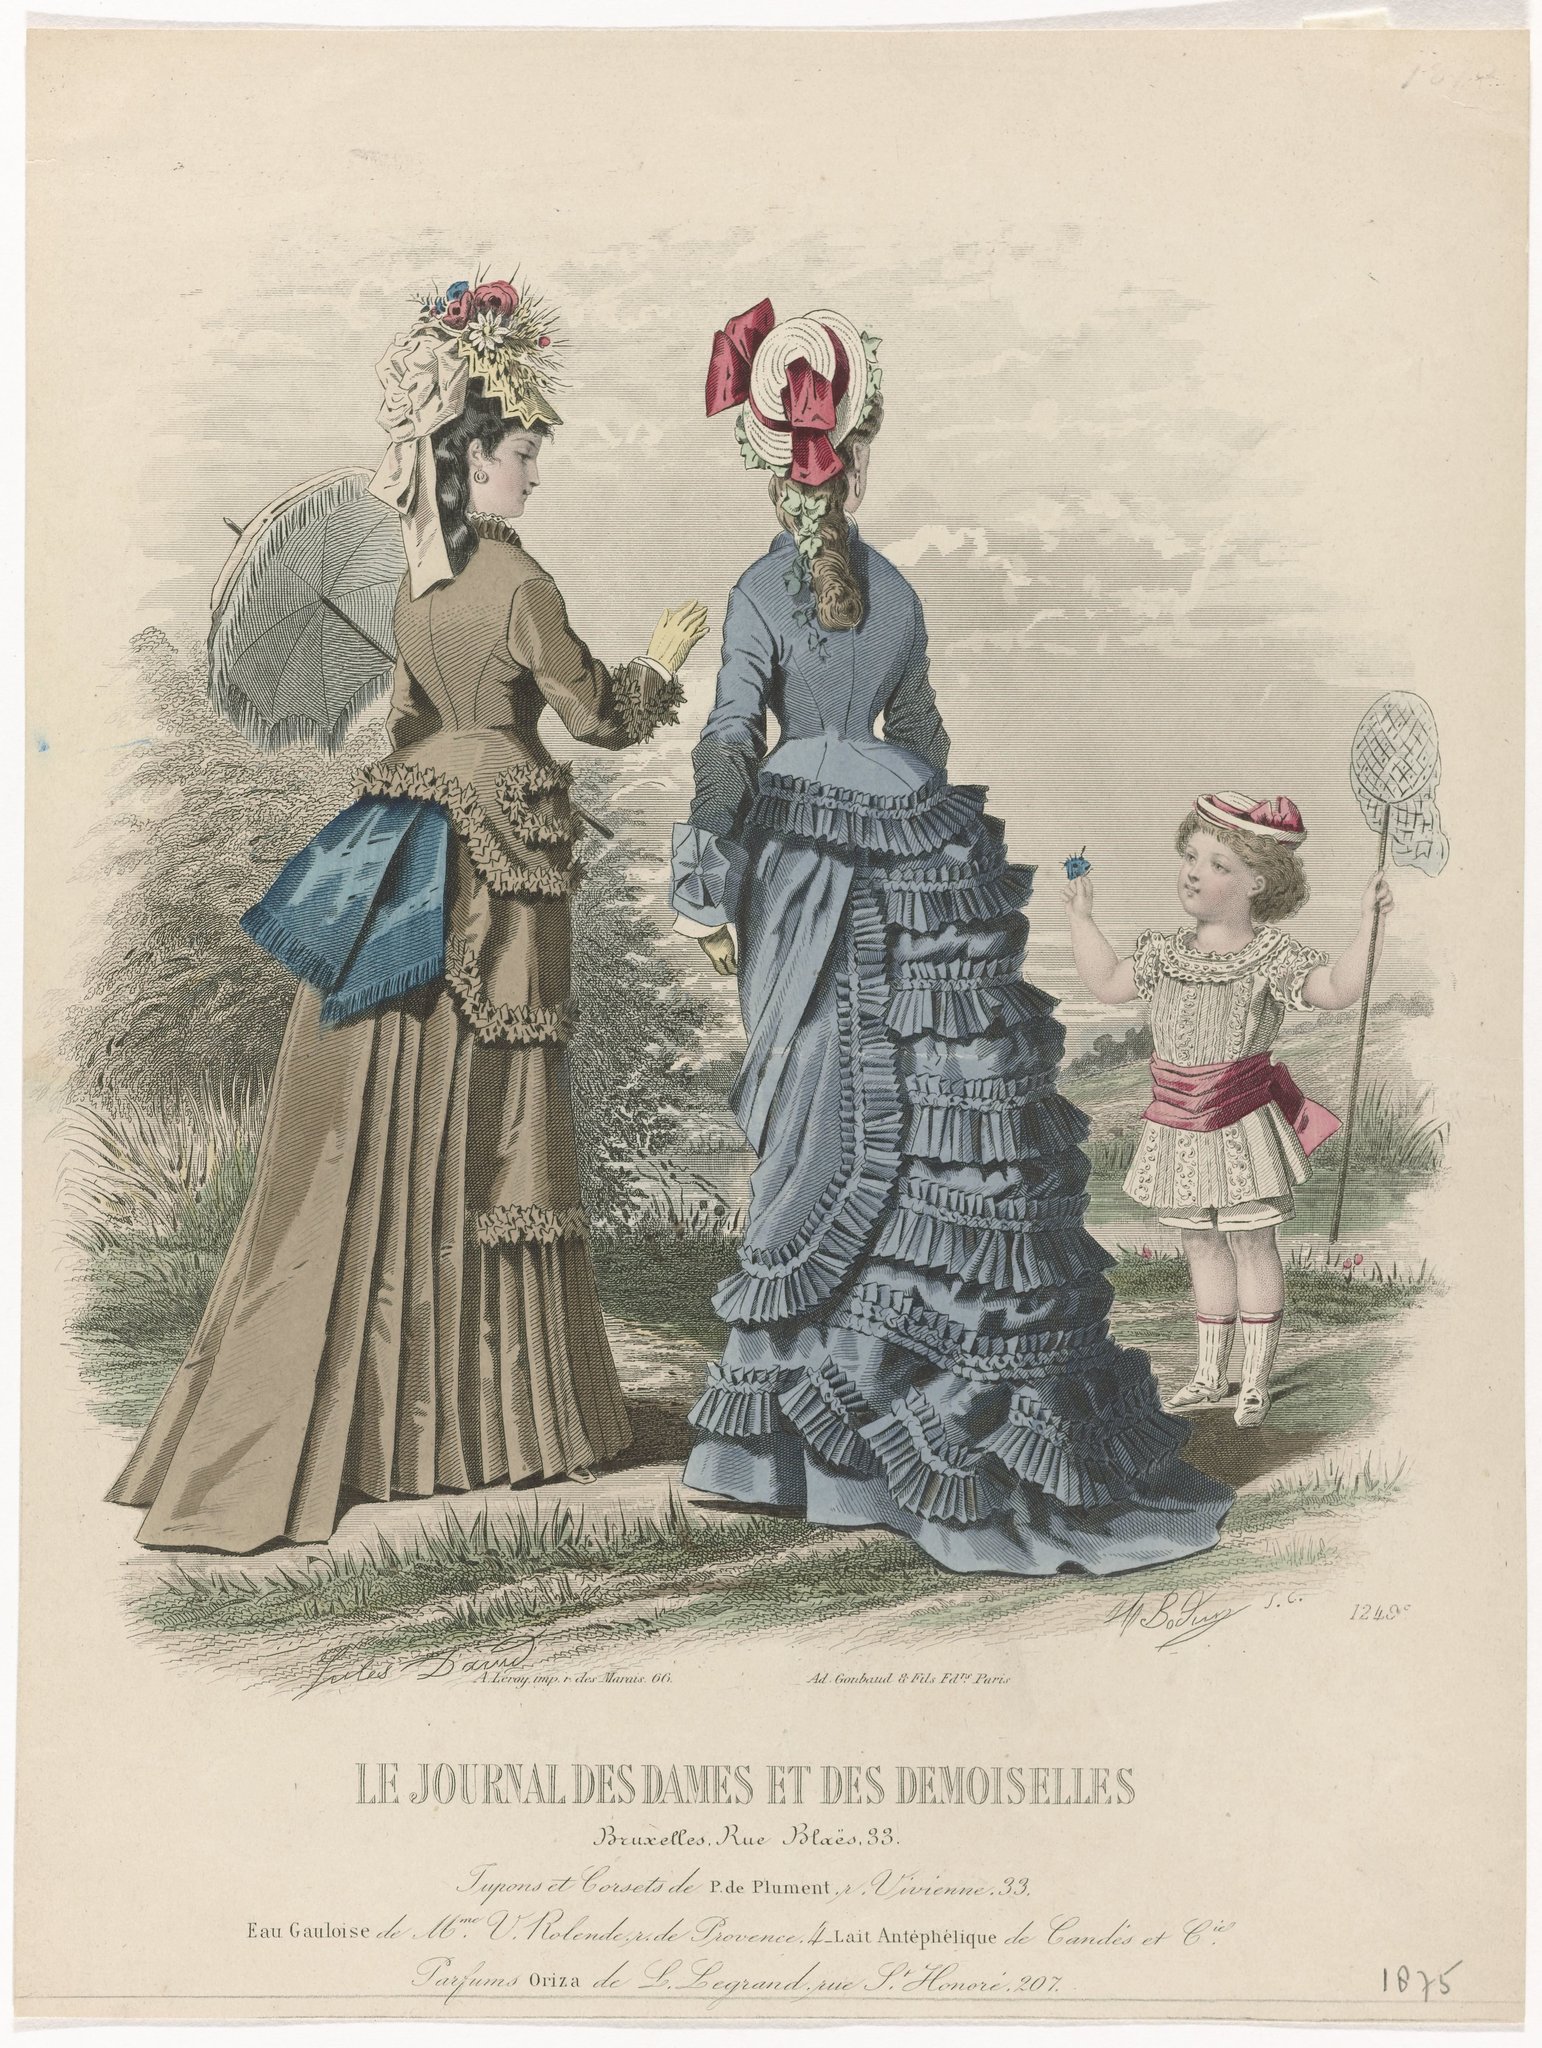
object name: fashion print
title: Le Journal des Dames et des Demoiselles, 1875, No. 1249e : Jupons et Corsets (...)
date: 1875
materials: paper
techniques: hand coloring, engraving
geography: paris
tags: stockings, socks (+ girls' clothes), head-gear (+ girls' clothes), shoes, sandals (+ girls' clothes), belt, girdle, waistband (+ girls' clothes), head-gear (+ women's clothes), fashion plates, gloves, mittens, etc. (+ women's clothes), dress, gown (+ women's clothes), hunting butterflies, insects: butterfly, parasol, sunshade (+ women's clothes), dress, gown (+ girls' clothes)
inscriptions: title: ‘Le Journal des Dames et des Demoiselles’, caption: ‘Jupons et Corsets de P. de Plument,r, Vivienne, 33. Eau Gauloise de Mme V. Rolende,r, de Provence,4 _ Lait Antéphélique de Candés et Cie. Parfums Oriza de L.Legrand, rue St Honoré.207.’, address: ‘Bruxelles, Rue Blaës, 33.’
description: Twee vrouwen en een kind buiten, gekleed in wandelkledij. Zij dragen een jasje over een japon met tournure en een jasje afgewerkt met gerimpelde stof. Onder de voorstelling enkele regels reclametekst voor verschillende producten. Prent uit het modetijdschrift Journal des Dames et des Demoiselles (1841-1902).